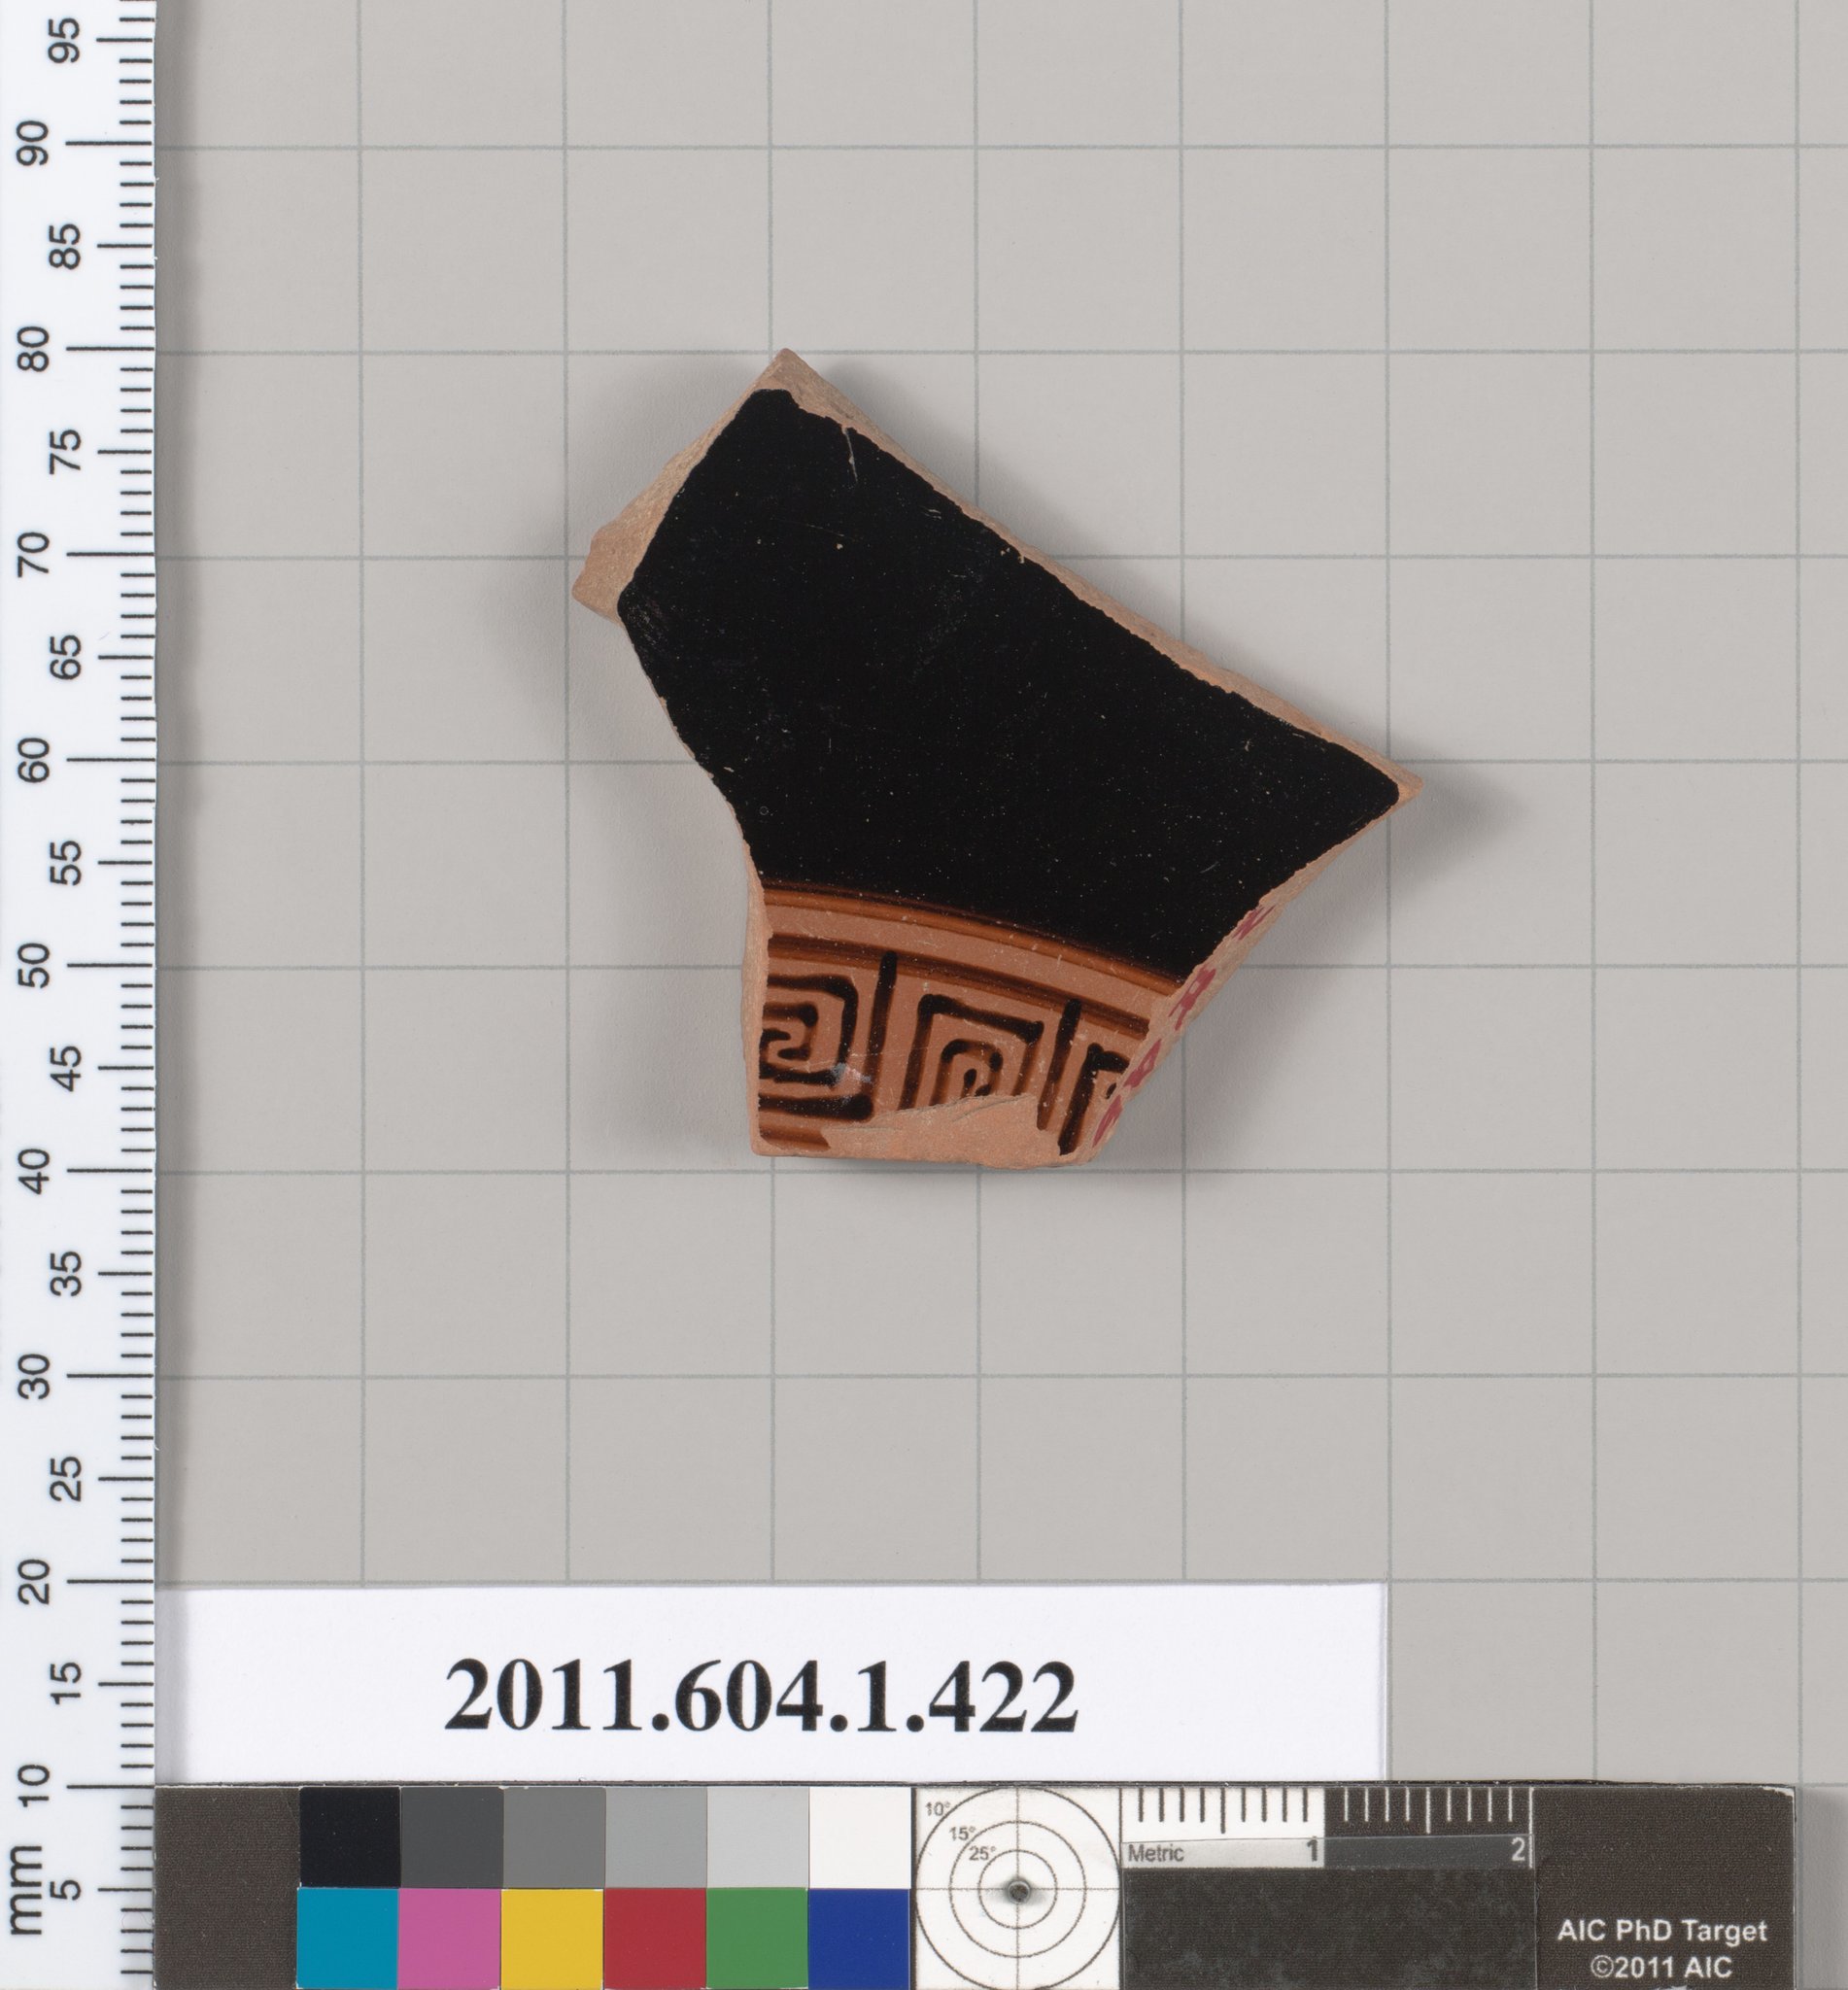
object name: kylix fragment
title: Terracotta fragment of a kylix (drinking cup)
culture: greek, attic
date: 475-451 BCE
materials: terracotta